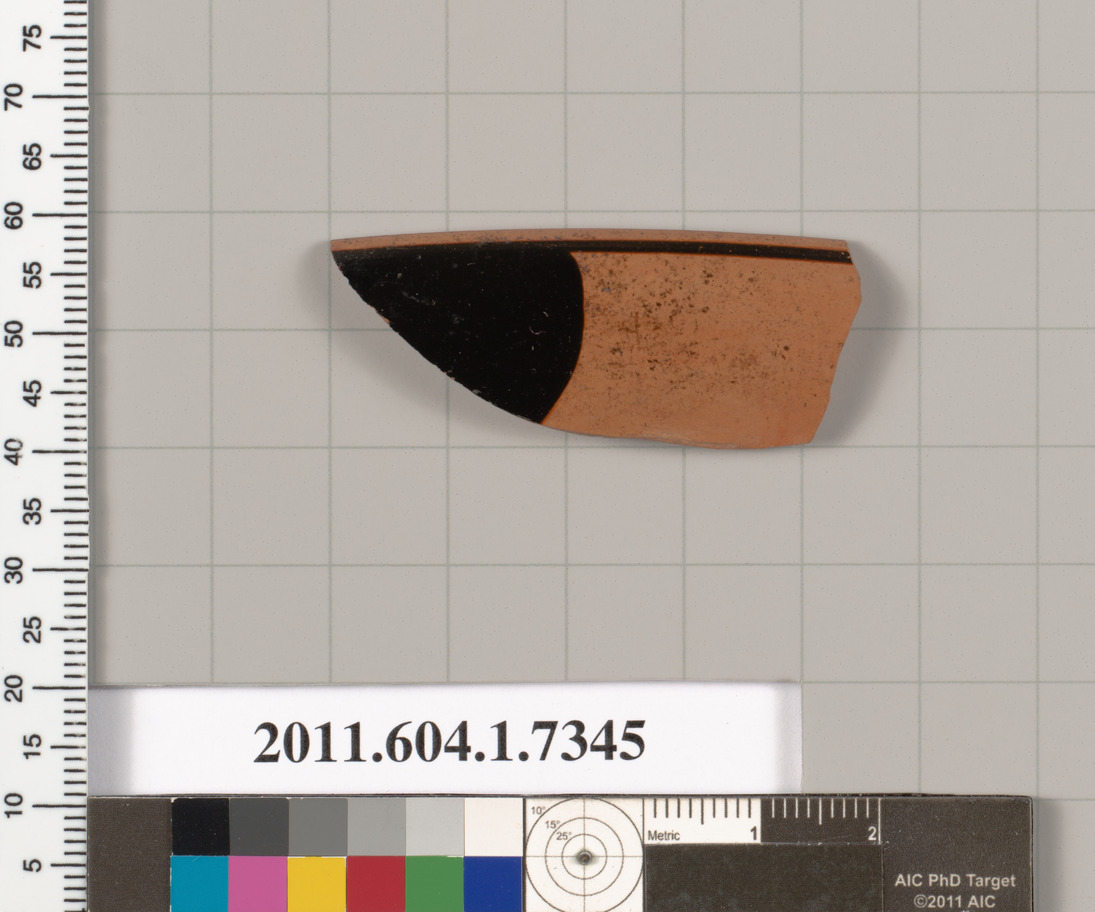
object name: kylix fragment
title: Terracotta rim fragment of a kylix (drinking cup)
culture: greek, attic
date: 500-480 BCE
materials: terracotta